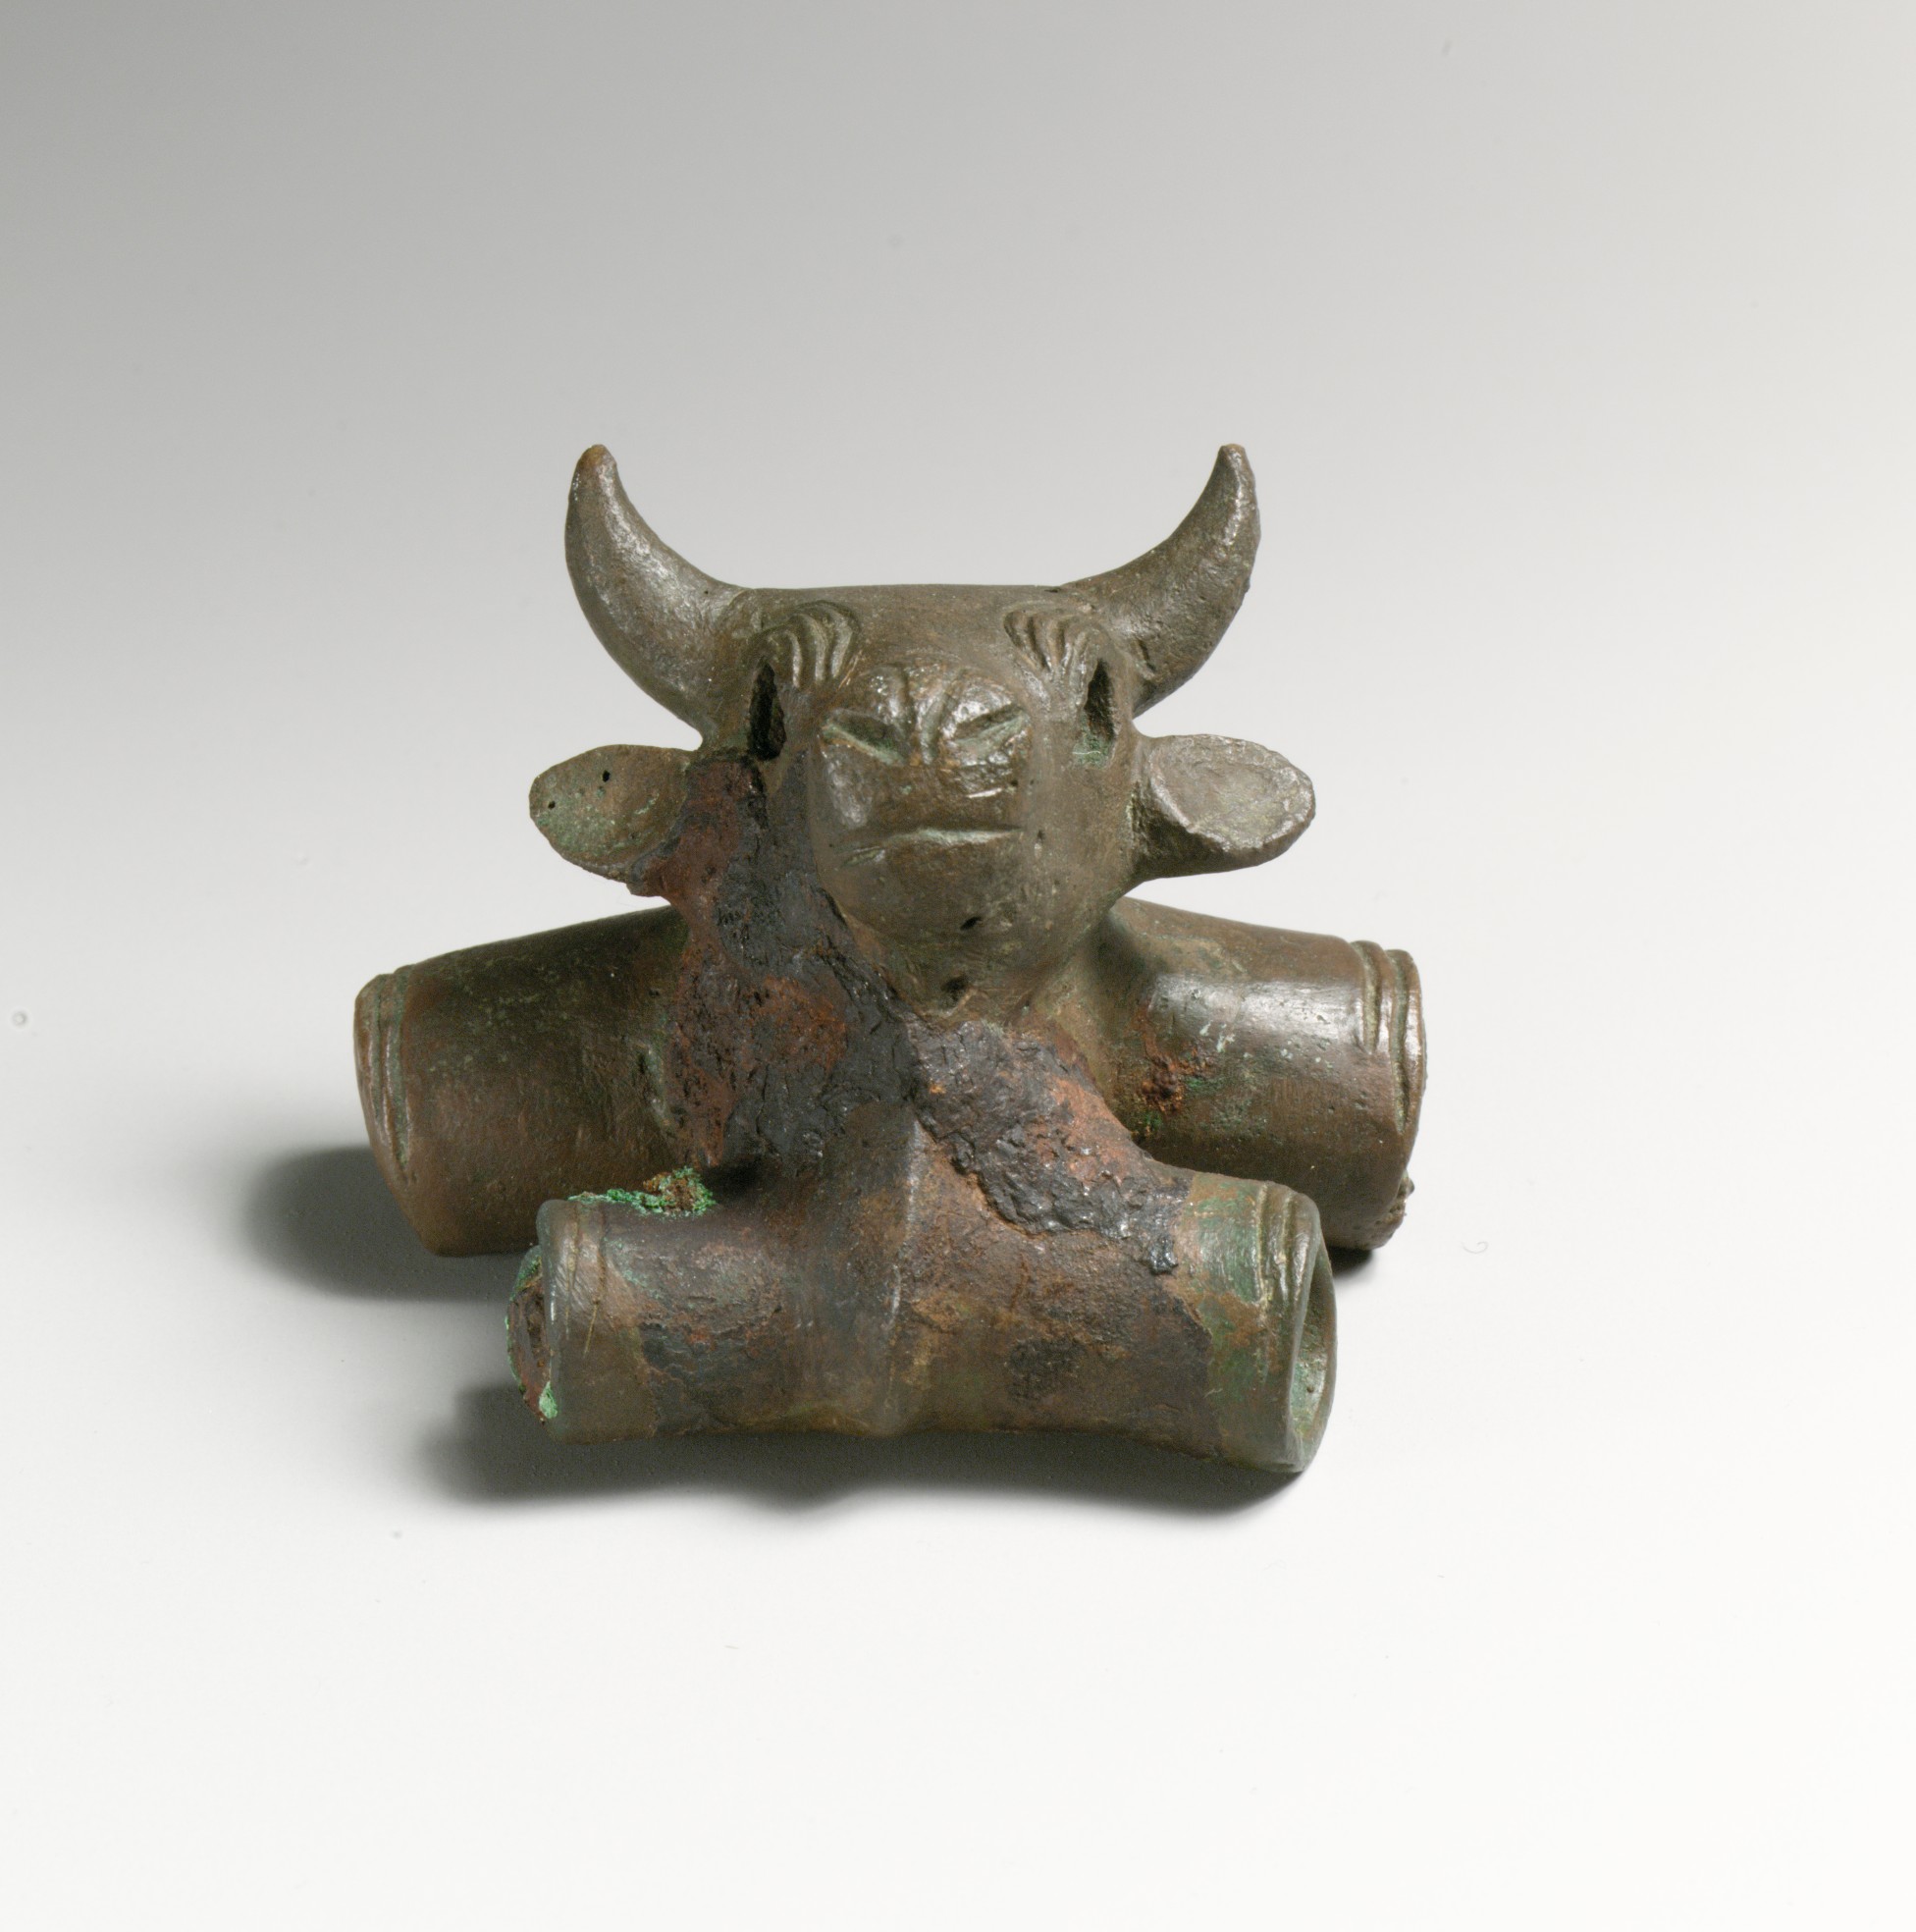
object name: attachment in the form of a bull's head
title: Bronze bull's head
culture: cypriot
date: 700-668 BCE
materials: bronze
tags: bulls